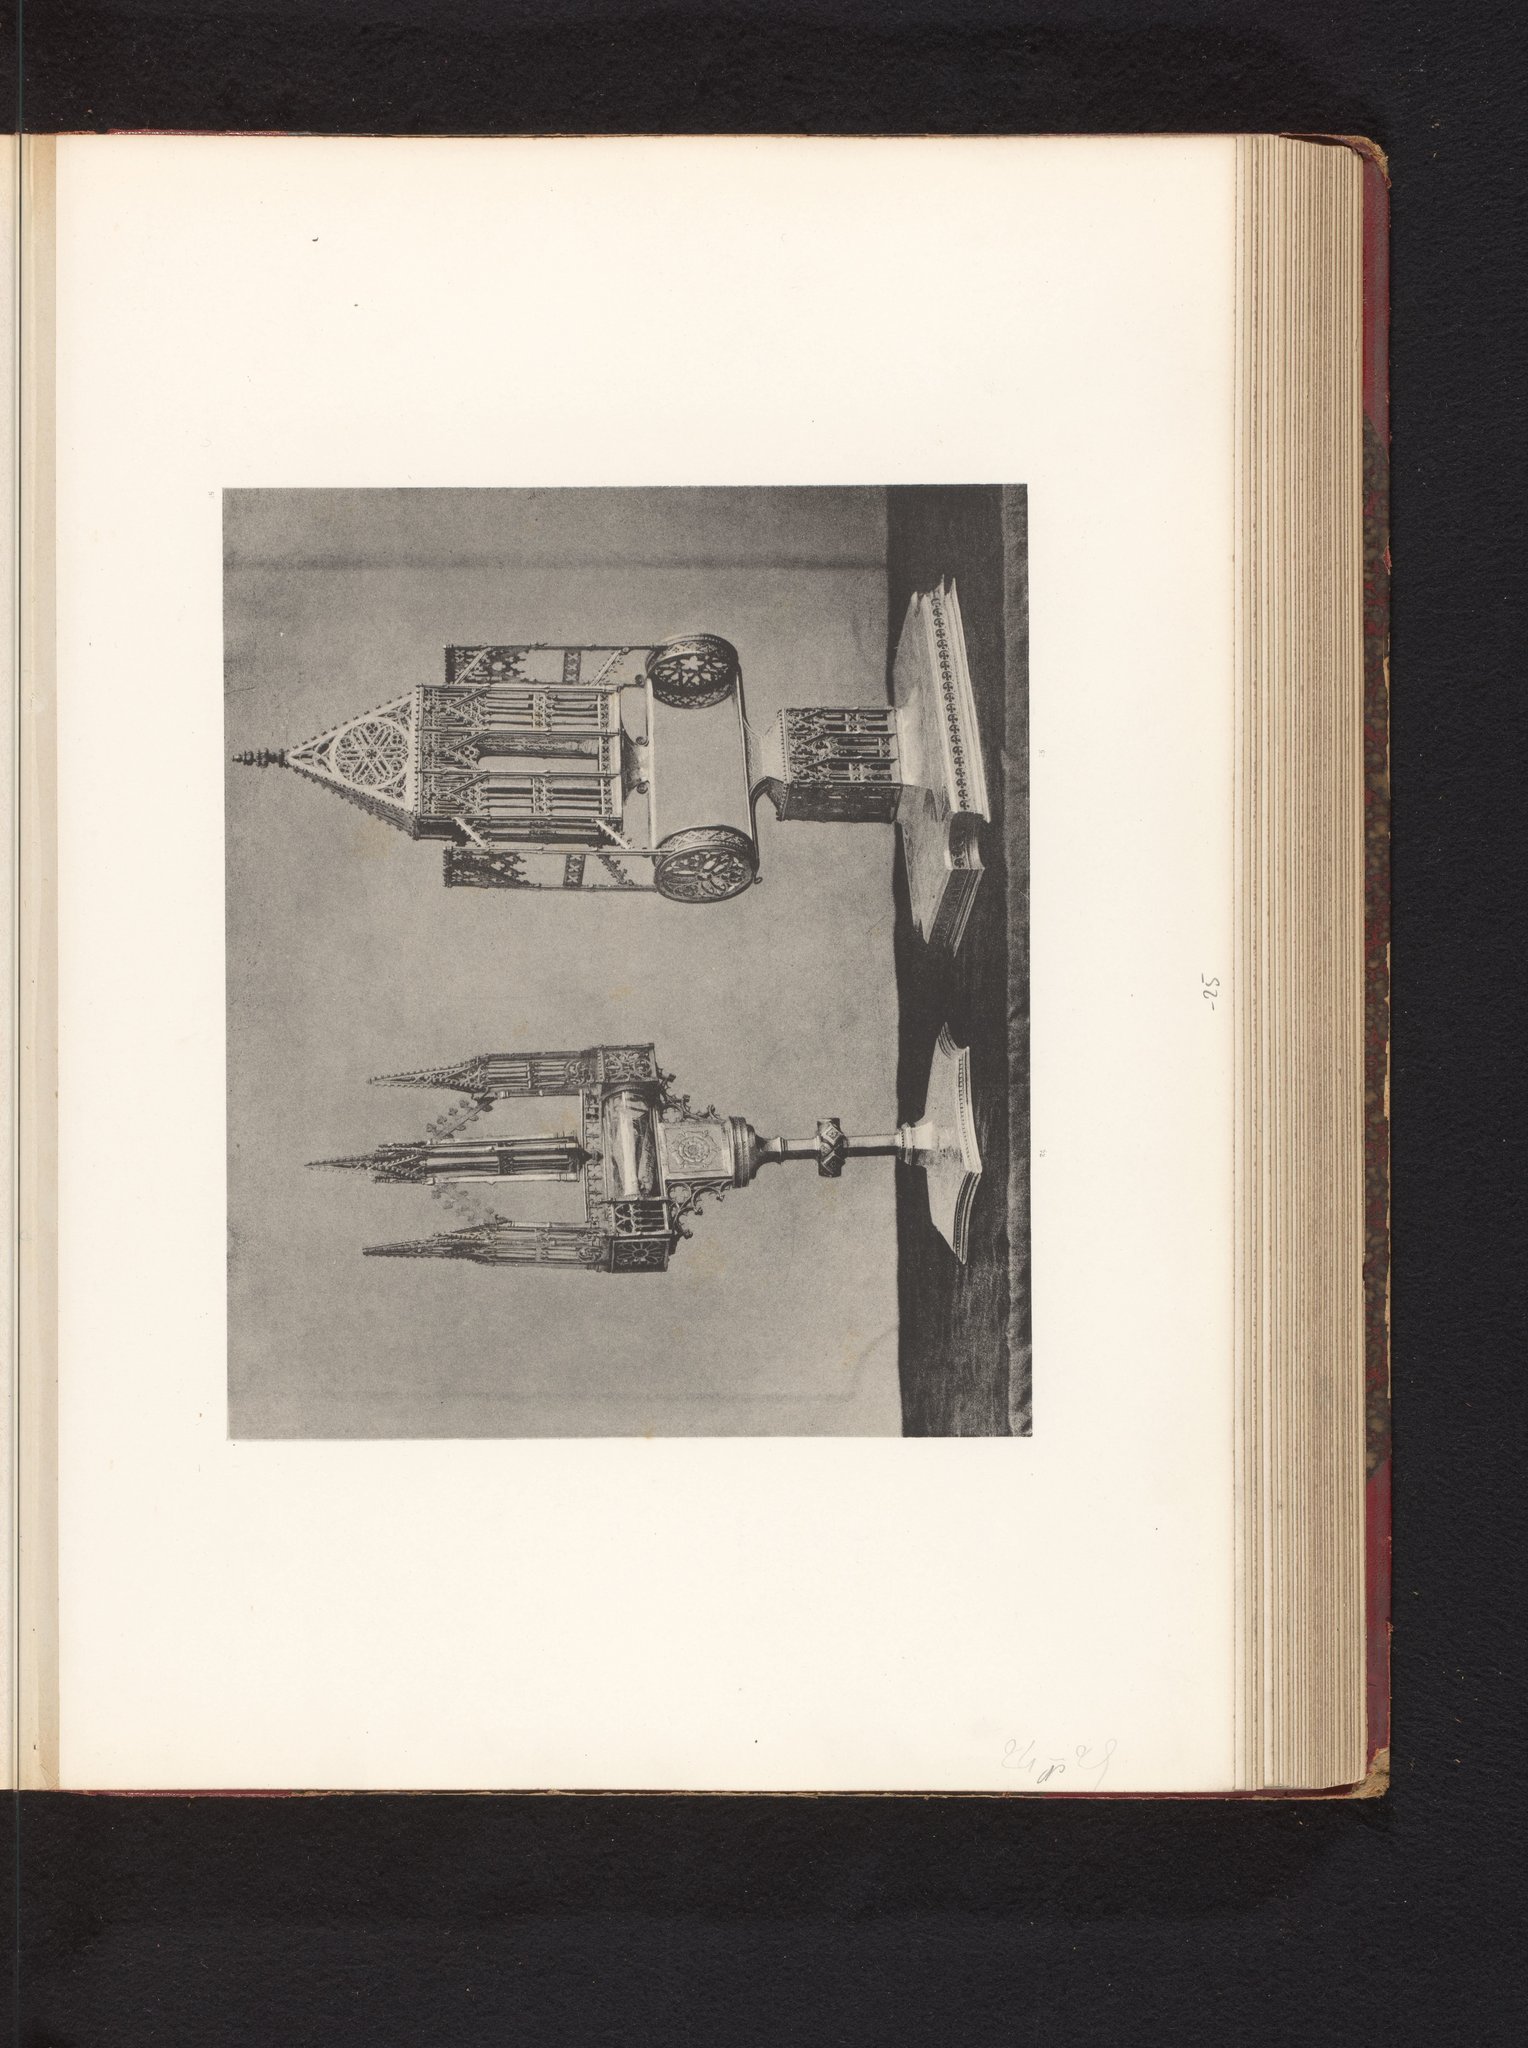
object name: page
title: Twee zilveren monstransen met relikwieën, opgesteld op een tentoonstelling over religieuze objecten uit de middeleeuwen en renaissance in 1864 in Mechelen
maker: joseph maes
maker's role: fotograaf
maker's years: 1838-1908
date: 1864-1866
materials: paper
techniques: photolithography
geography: mechelen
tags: ostensorium, monstrance, relics (and reliquaries), mechelen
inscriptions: number: ‘-25’, number: ‘24 - 25’, number: ‘24 - 25’